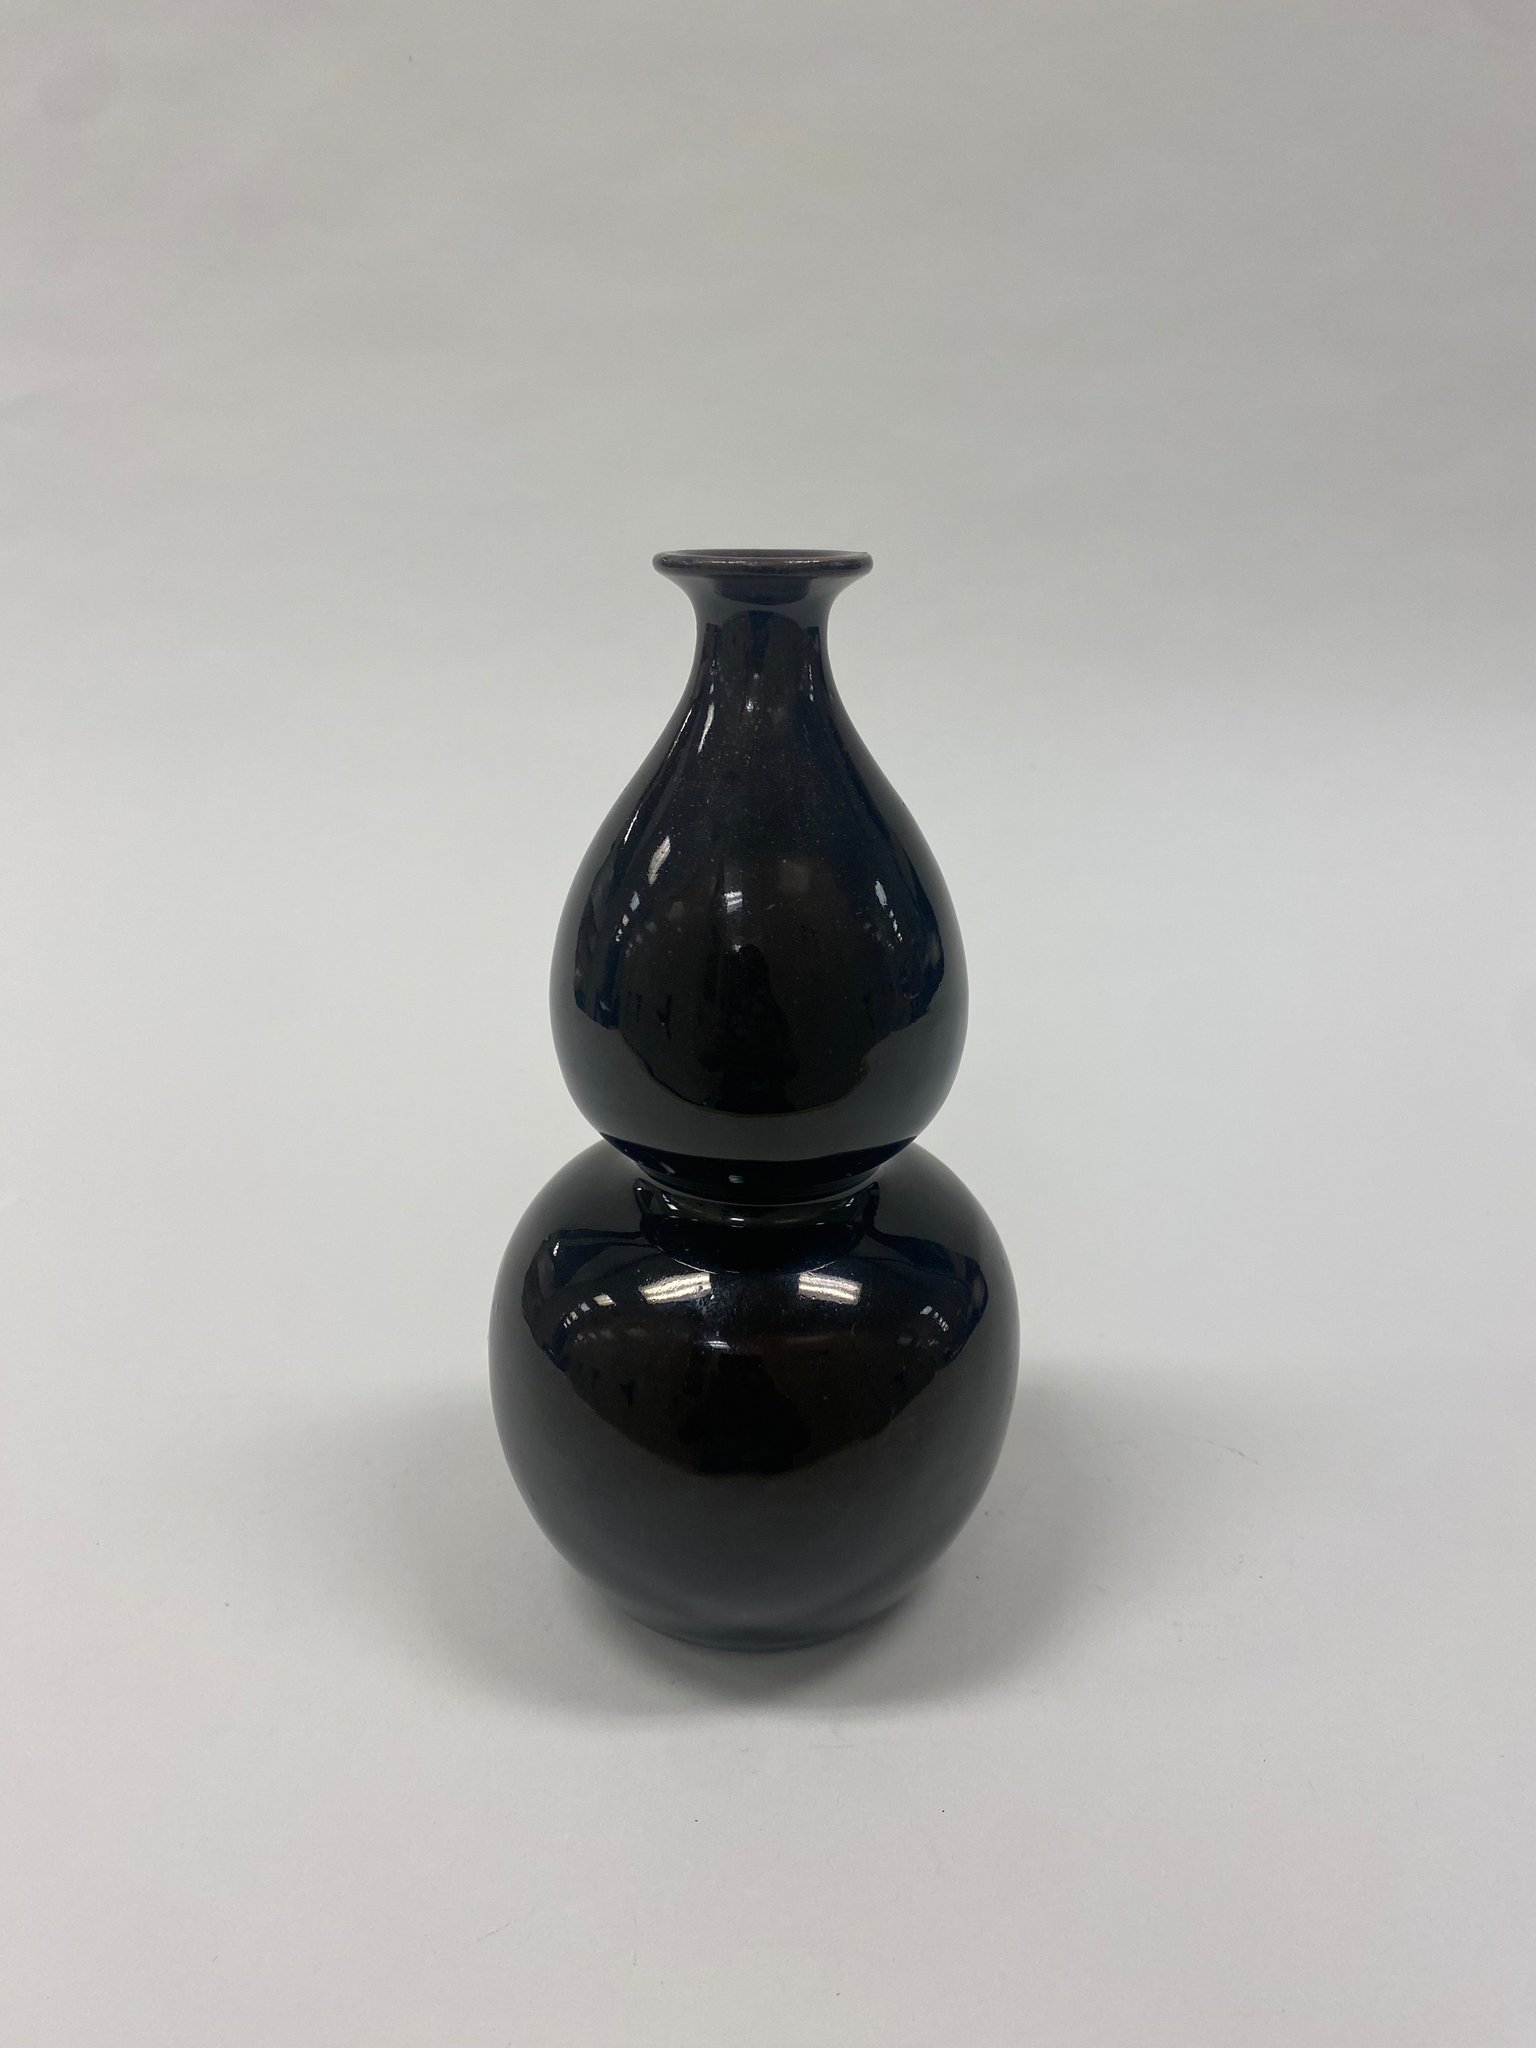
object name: bottle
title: Gourd-shaped bottle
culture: chinese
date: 1701-1800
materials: glaze, porcelain